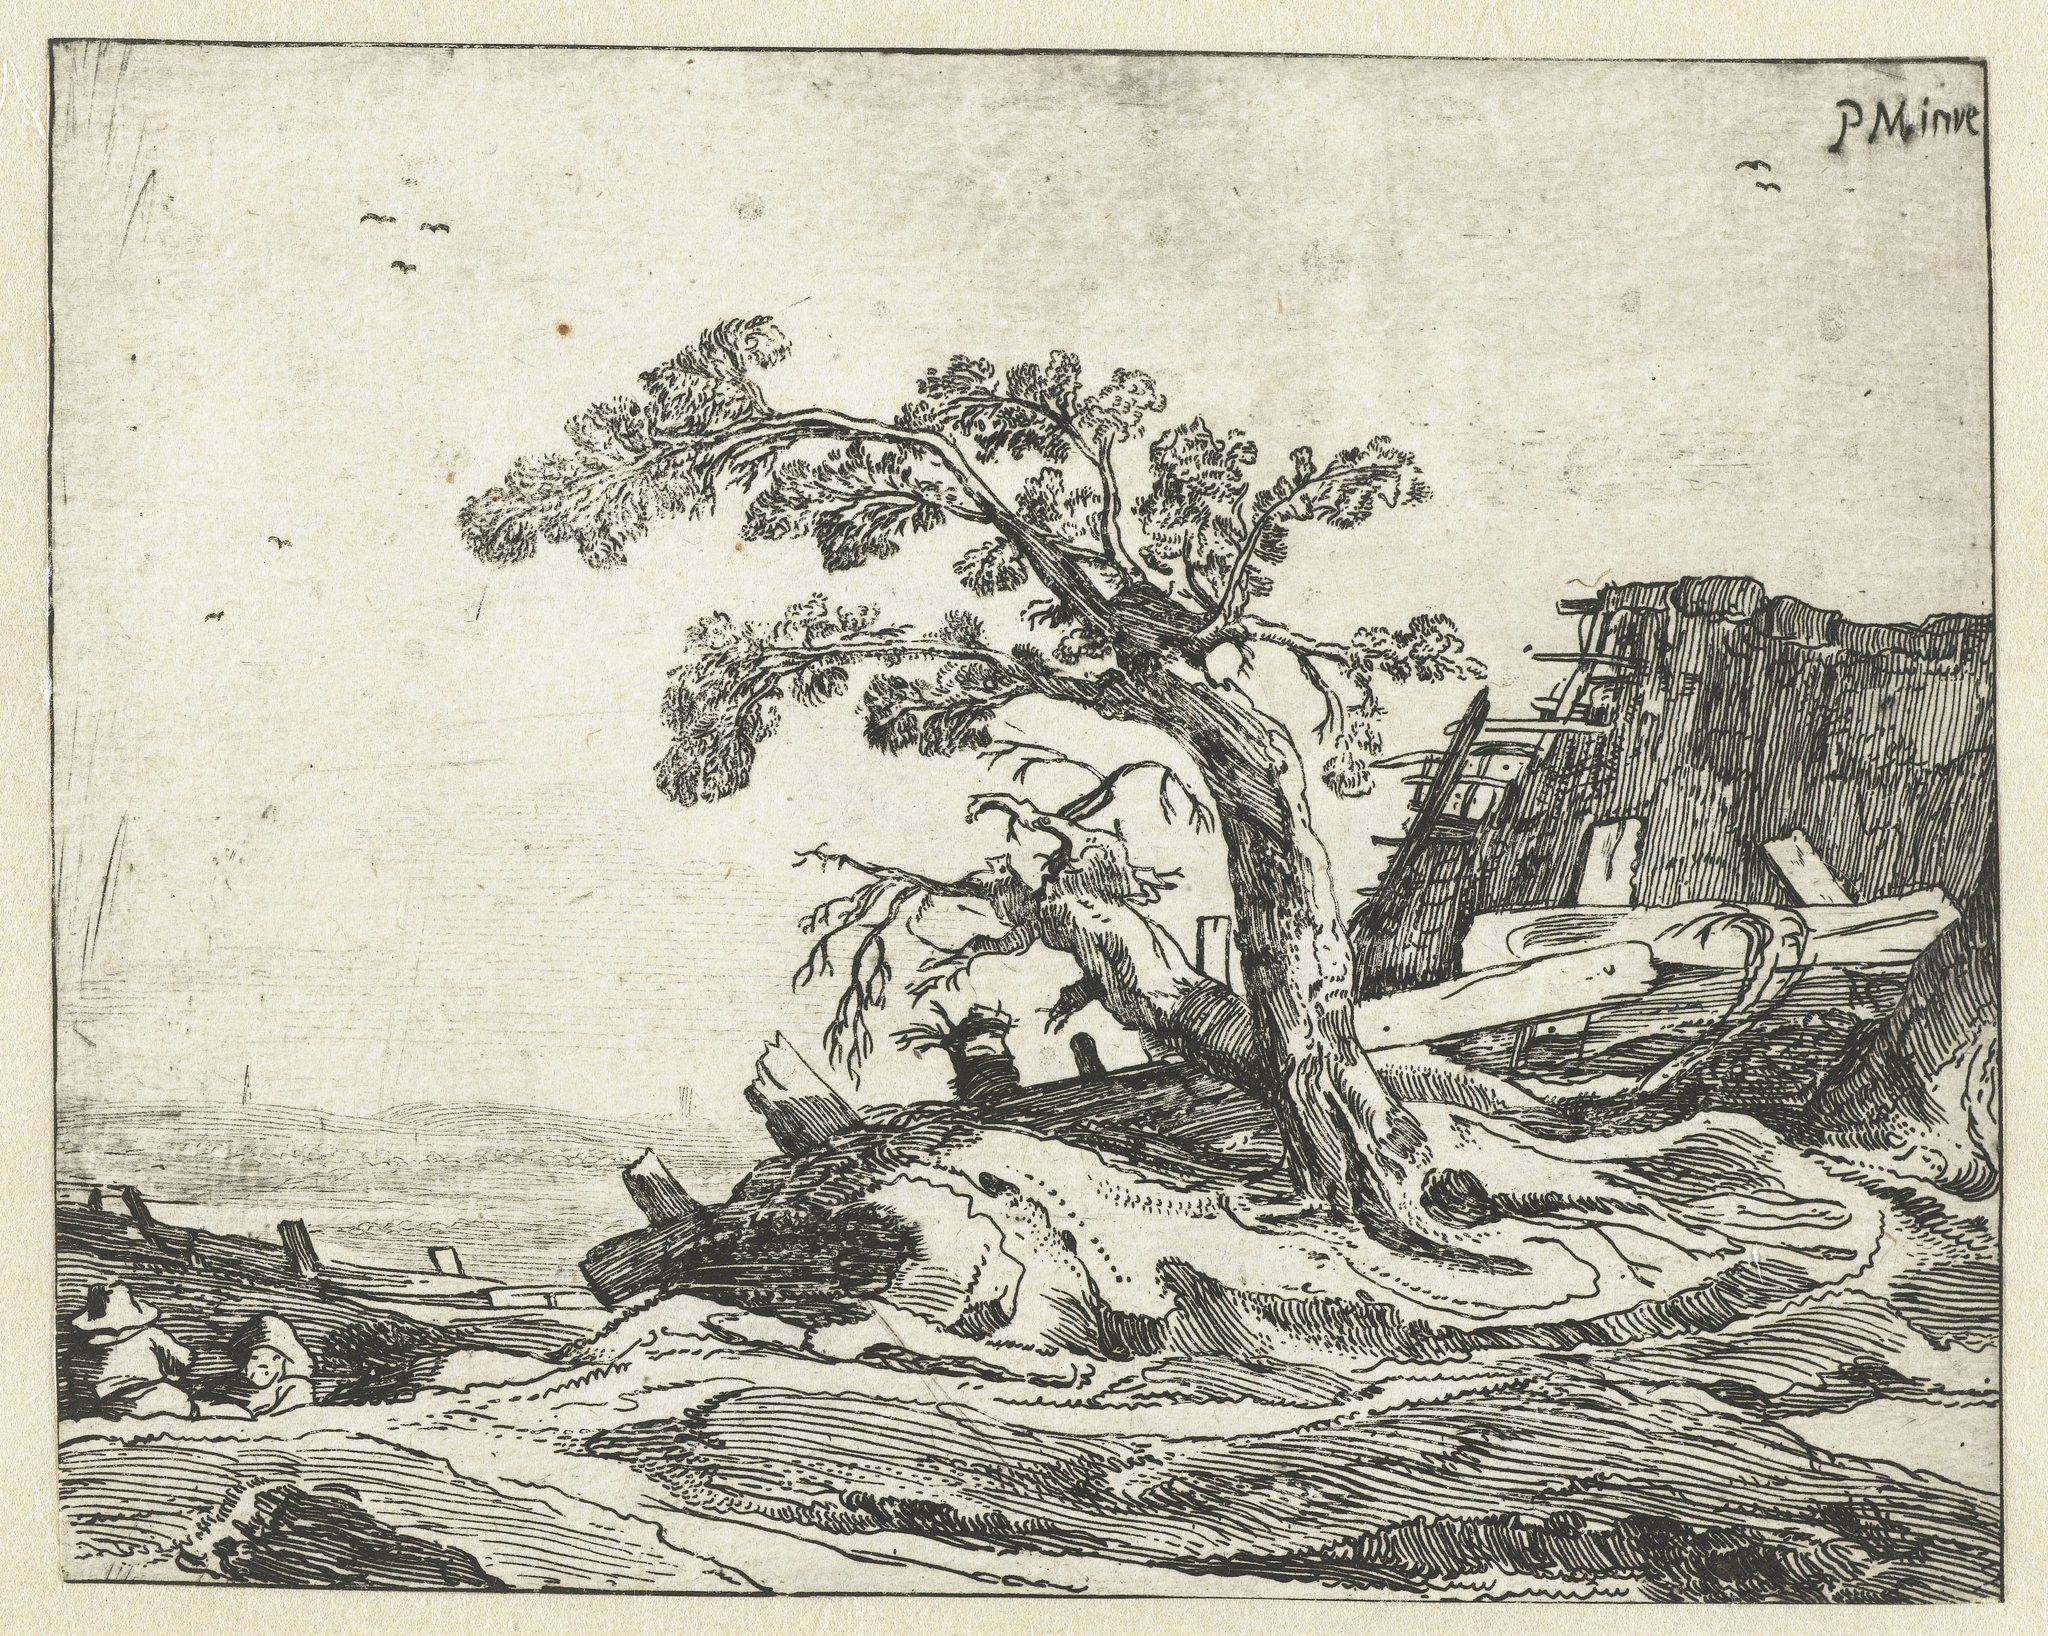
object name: print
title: Landschap met boom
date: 1623-1652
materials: paper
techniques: etching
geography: haarlem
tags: landscapes in the temperate zone, farm or solitary house in landscape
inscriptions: collector's mark: Lugt 2228a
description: Landschap met een boom bij een vervallen huis. Linksonder zitten of liggen twee figuren op de grond. Deze prent is onderdeel van een serie van vier prenten van landschappen met landlieden in hoofd- of bijrol.